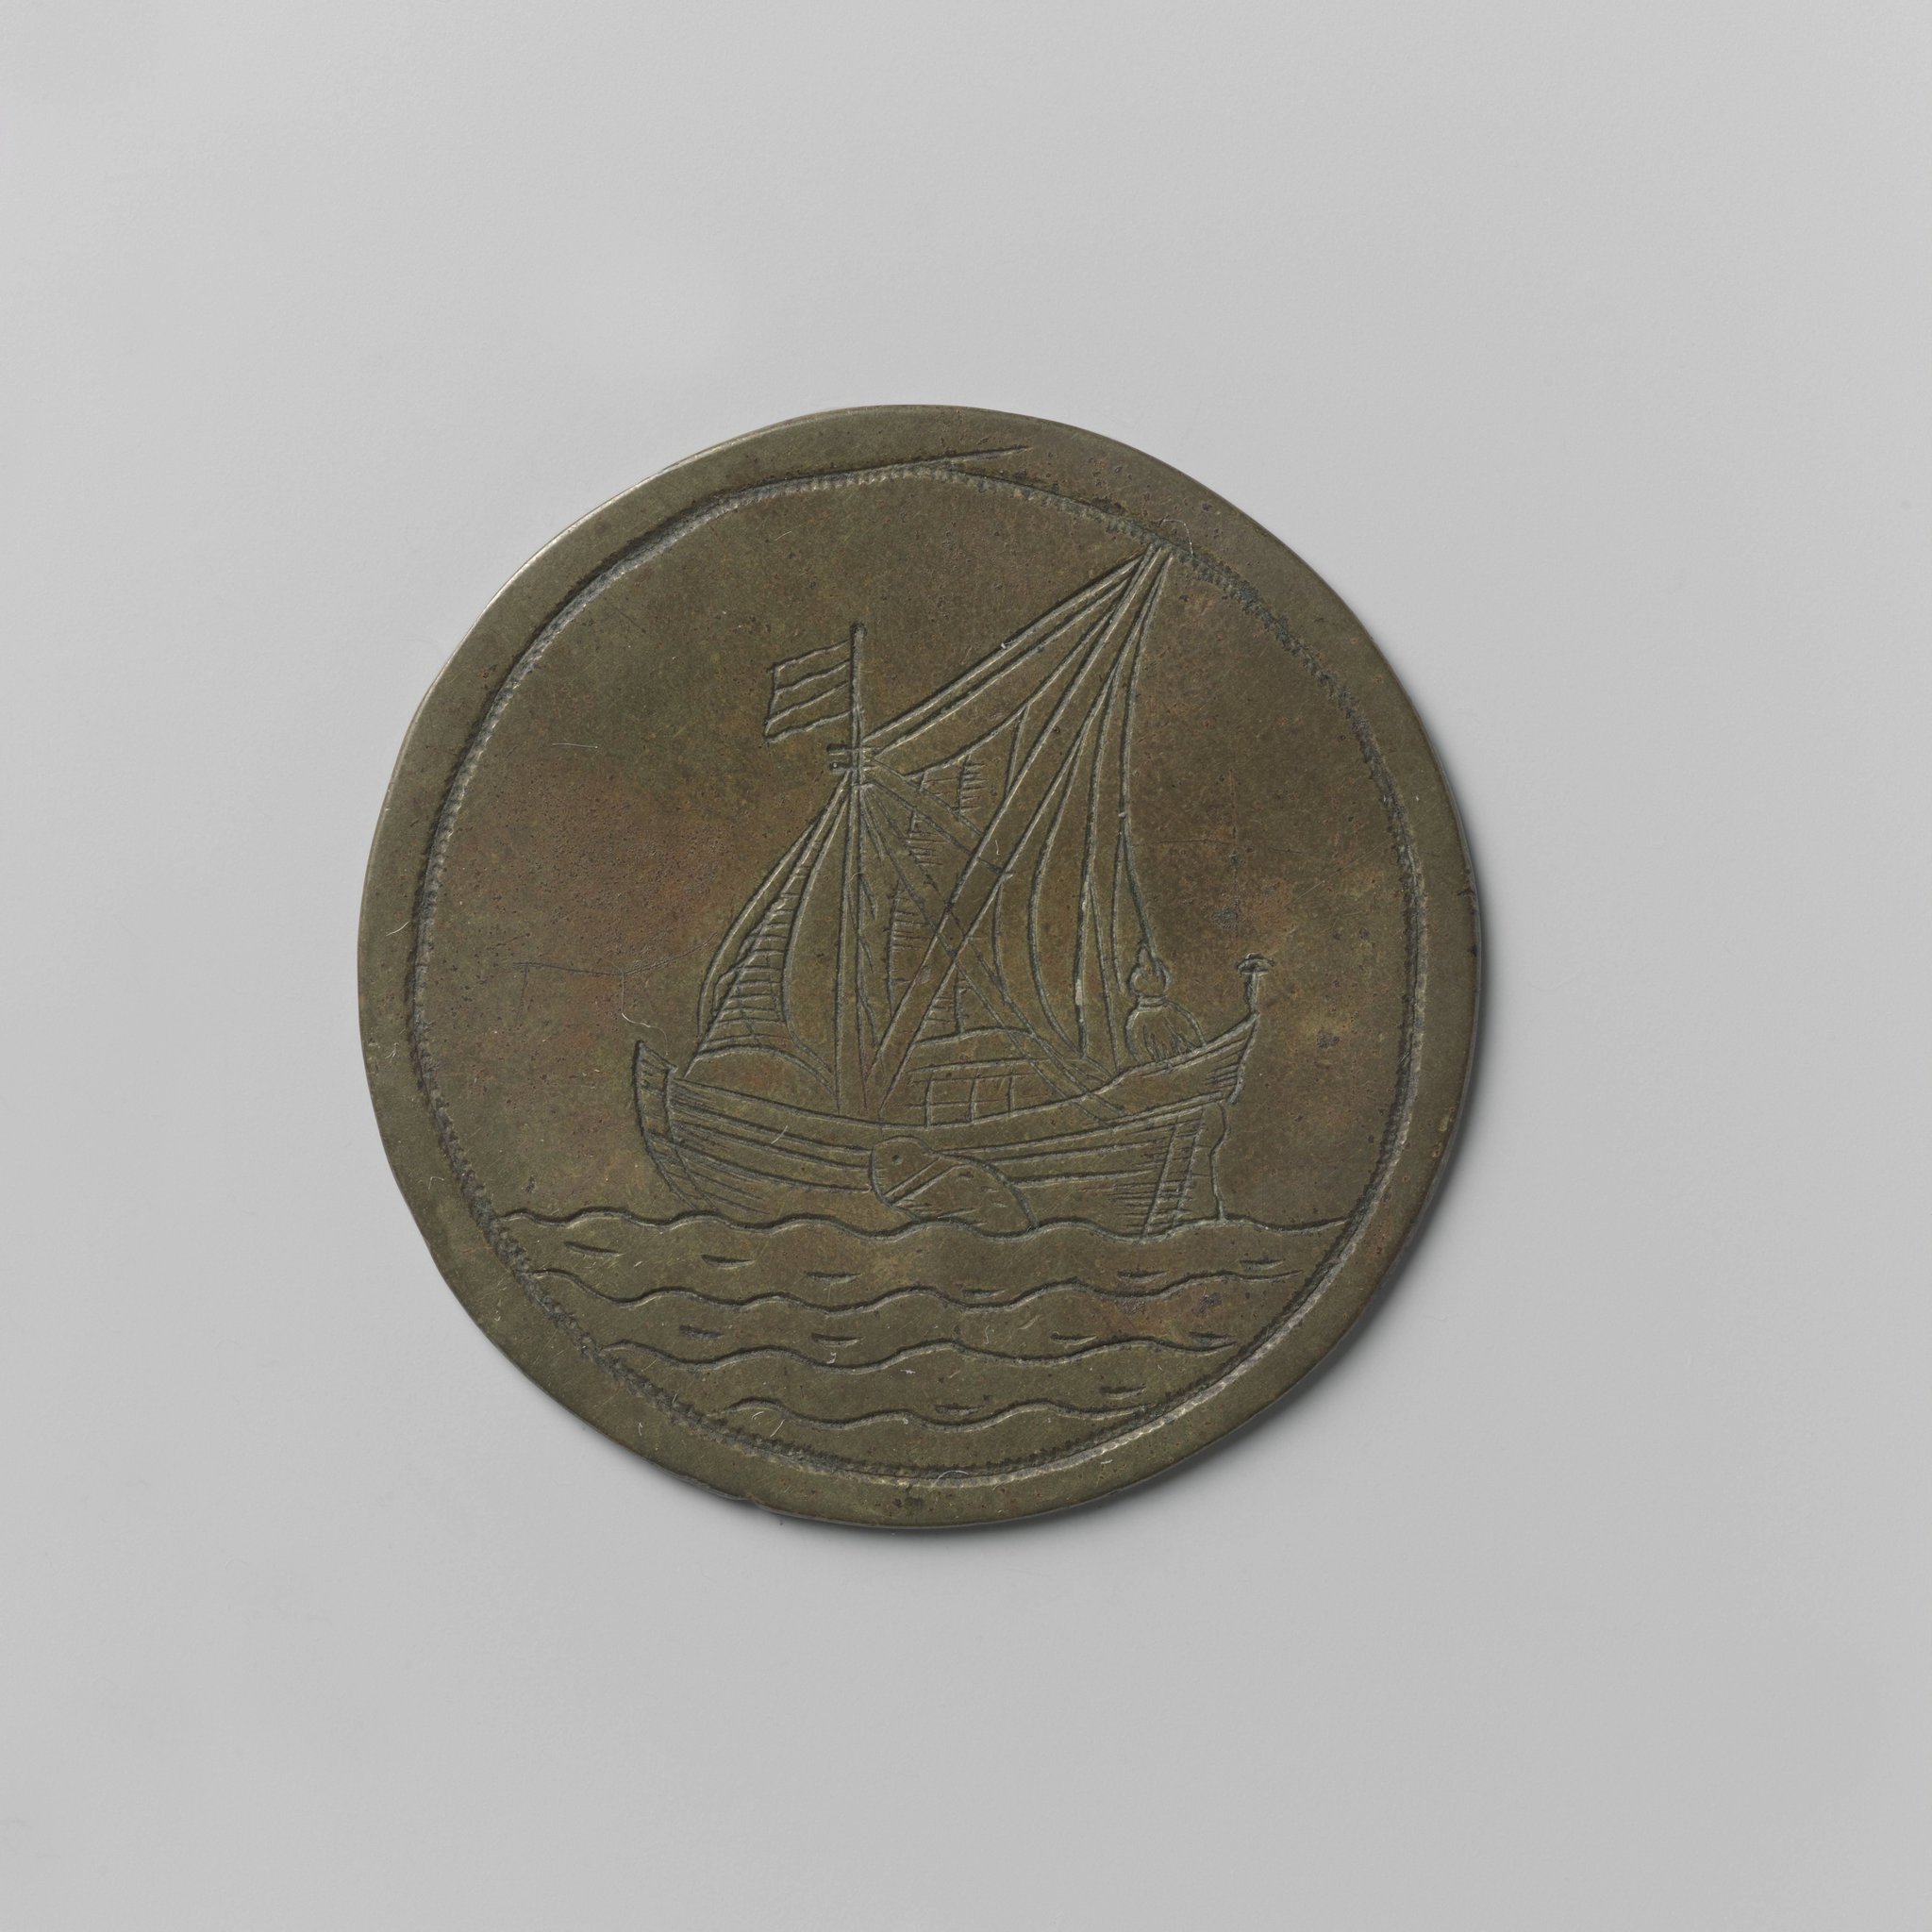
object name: medal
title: Schippersgilde, gildepenning van Cornelis Tonboeijer met no. 22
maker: Anonymous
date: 1800-1850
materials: brass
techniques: engraving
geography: netherlands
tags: cornelis tonboeijer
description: Messing penning. Voorzijde: naar links varend schip; op achterplecht: man. Keerzijde: opschrift onder cijfer 22 binnen dubbele cirkel.